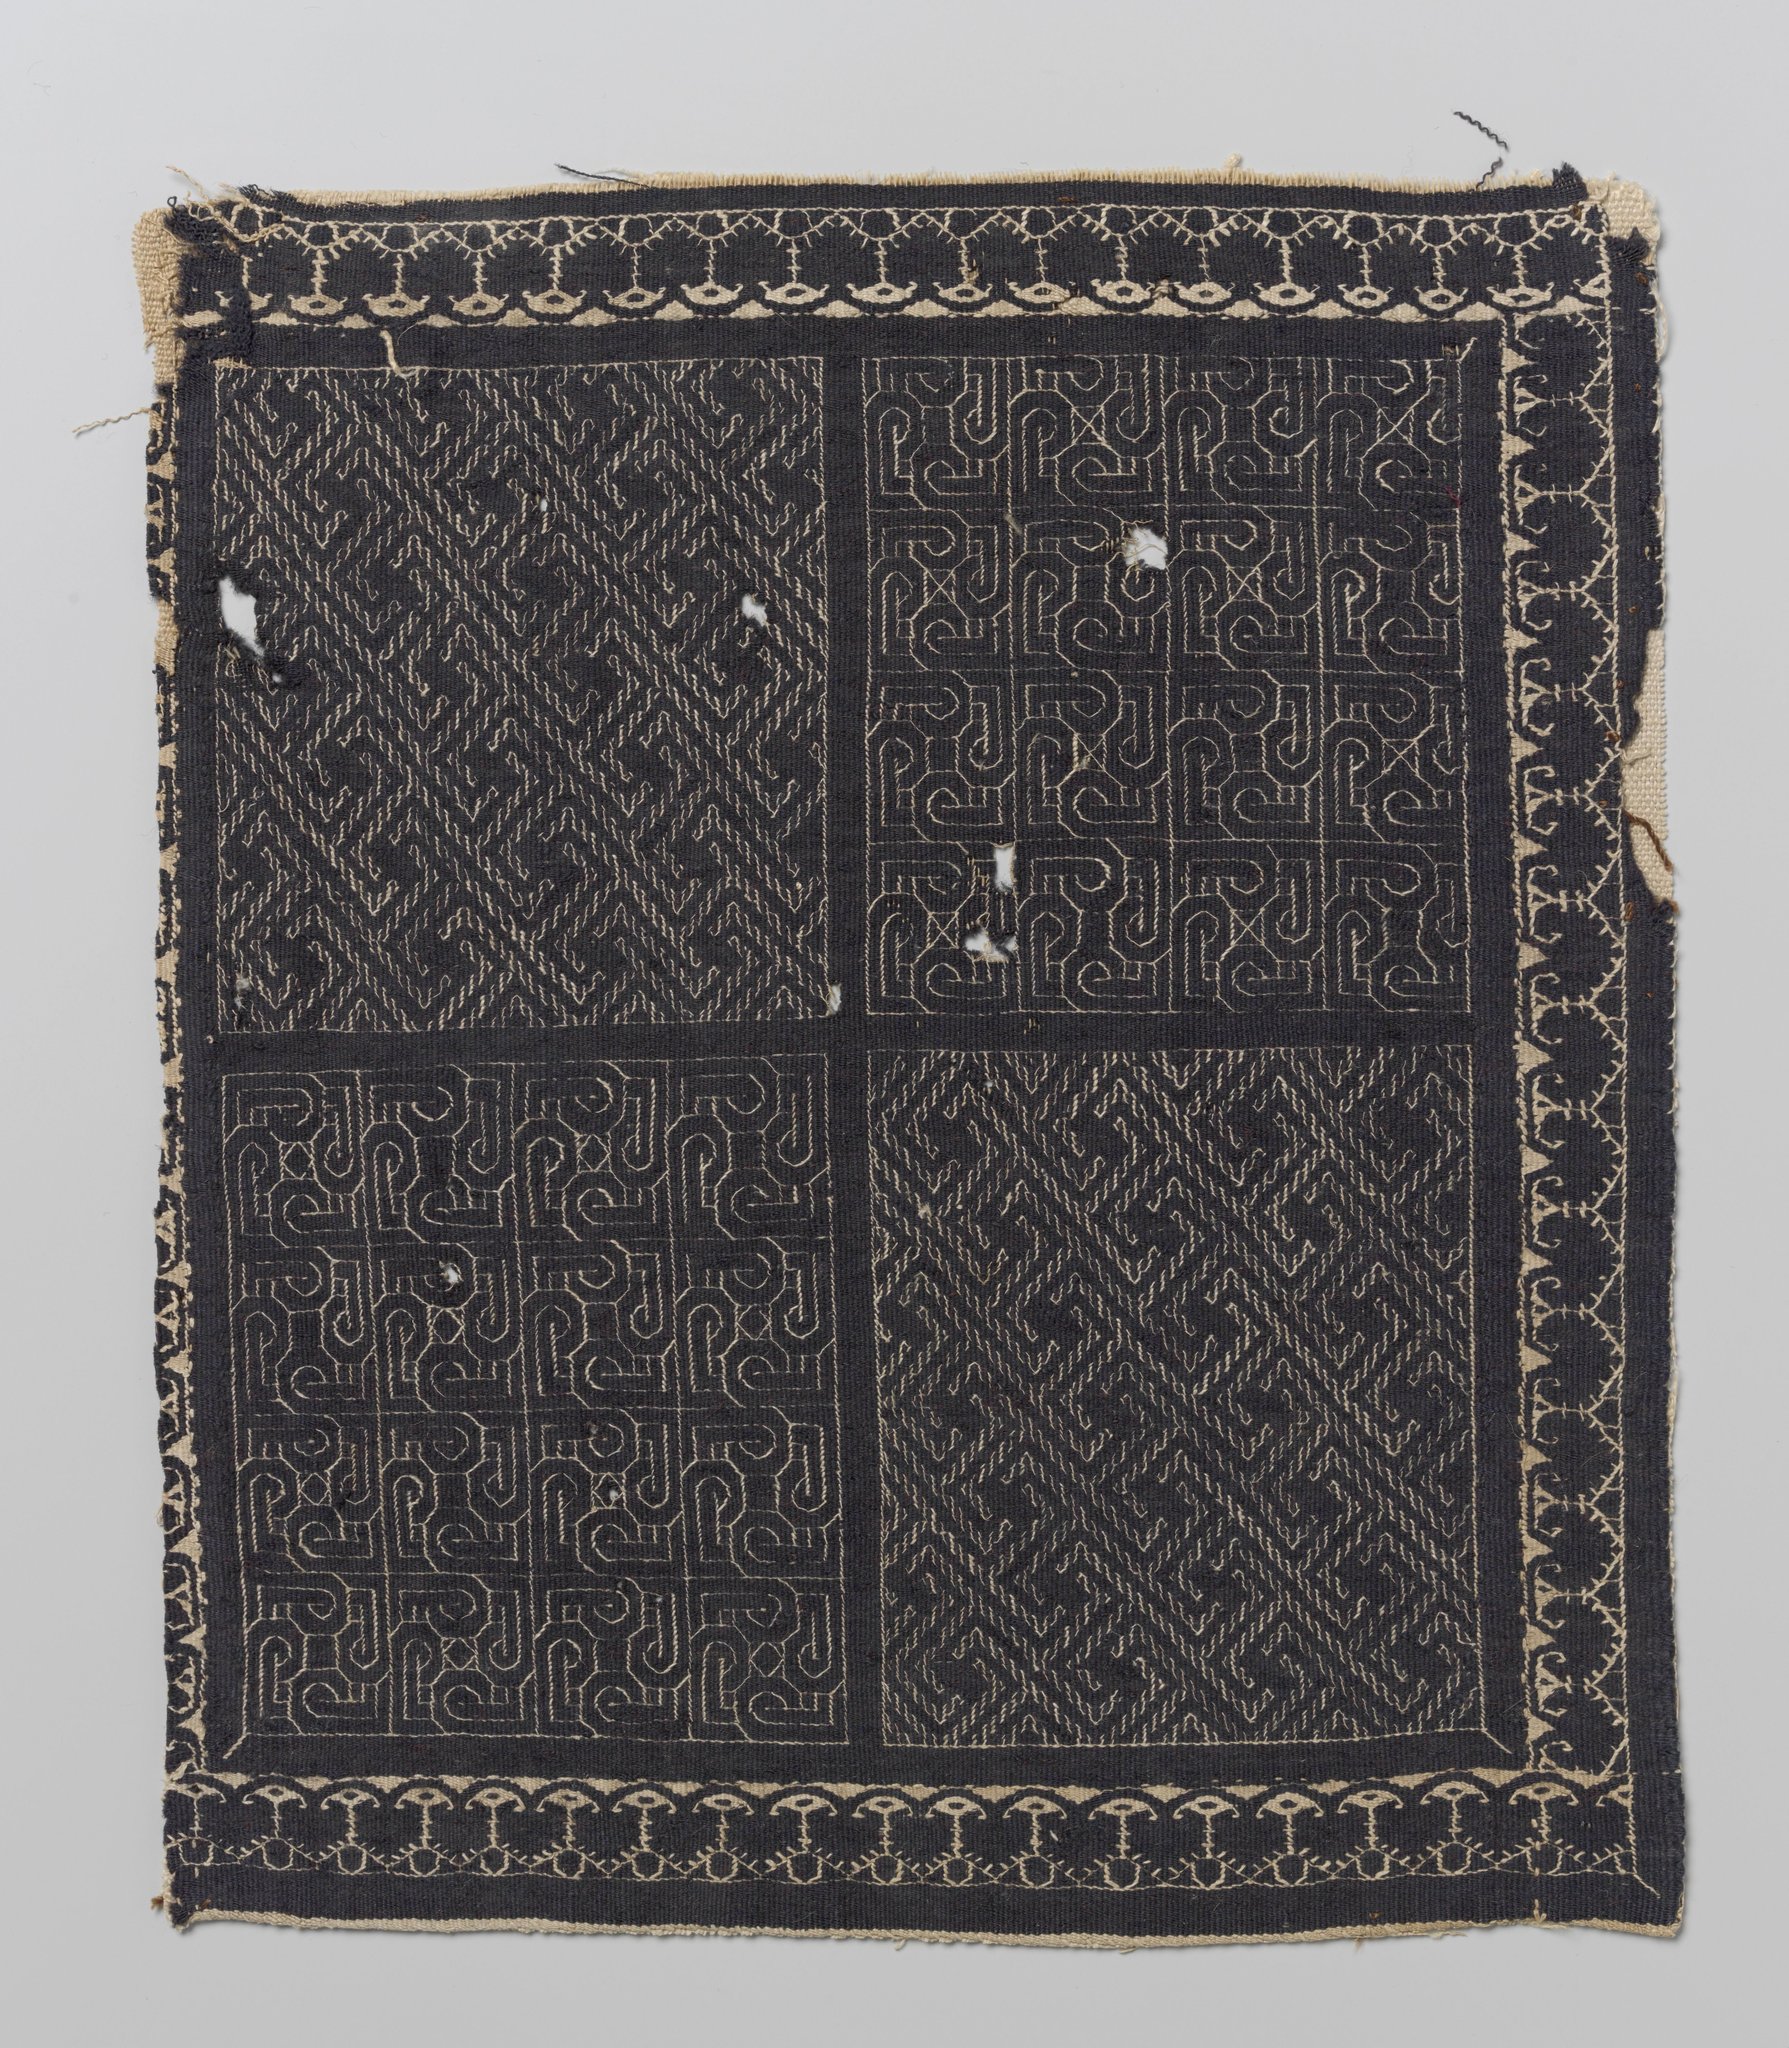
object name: tabula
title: Weefselfragment met tabula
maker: Anonymous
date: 300-599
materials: linen, wool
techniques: weave, tapestry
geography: egypt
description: Naturelkleurig linnen weefselfragment met opgenaaide tabula in donkerblauw. Het vlak is in vieren verdeeld met dwars tegenover elkaar hetzelfde geometrische motief in vliegende draadtechniek met enerzijds 16 vakken met naast elkaar geplaatst krulmotief, anderzijds een diagonaal lopend hoekig T-motief. Om het geheel een rand met hartvormig lopend ornament.